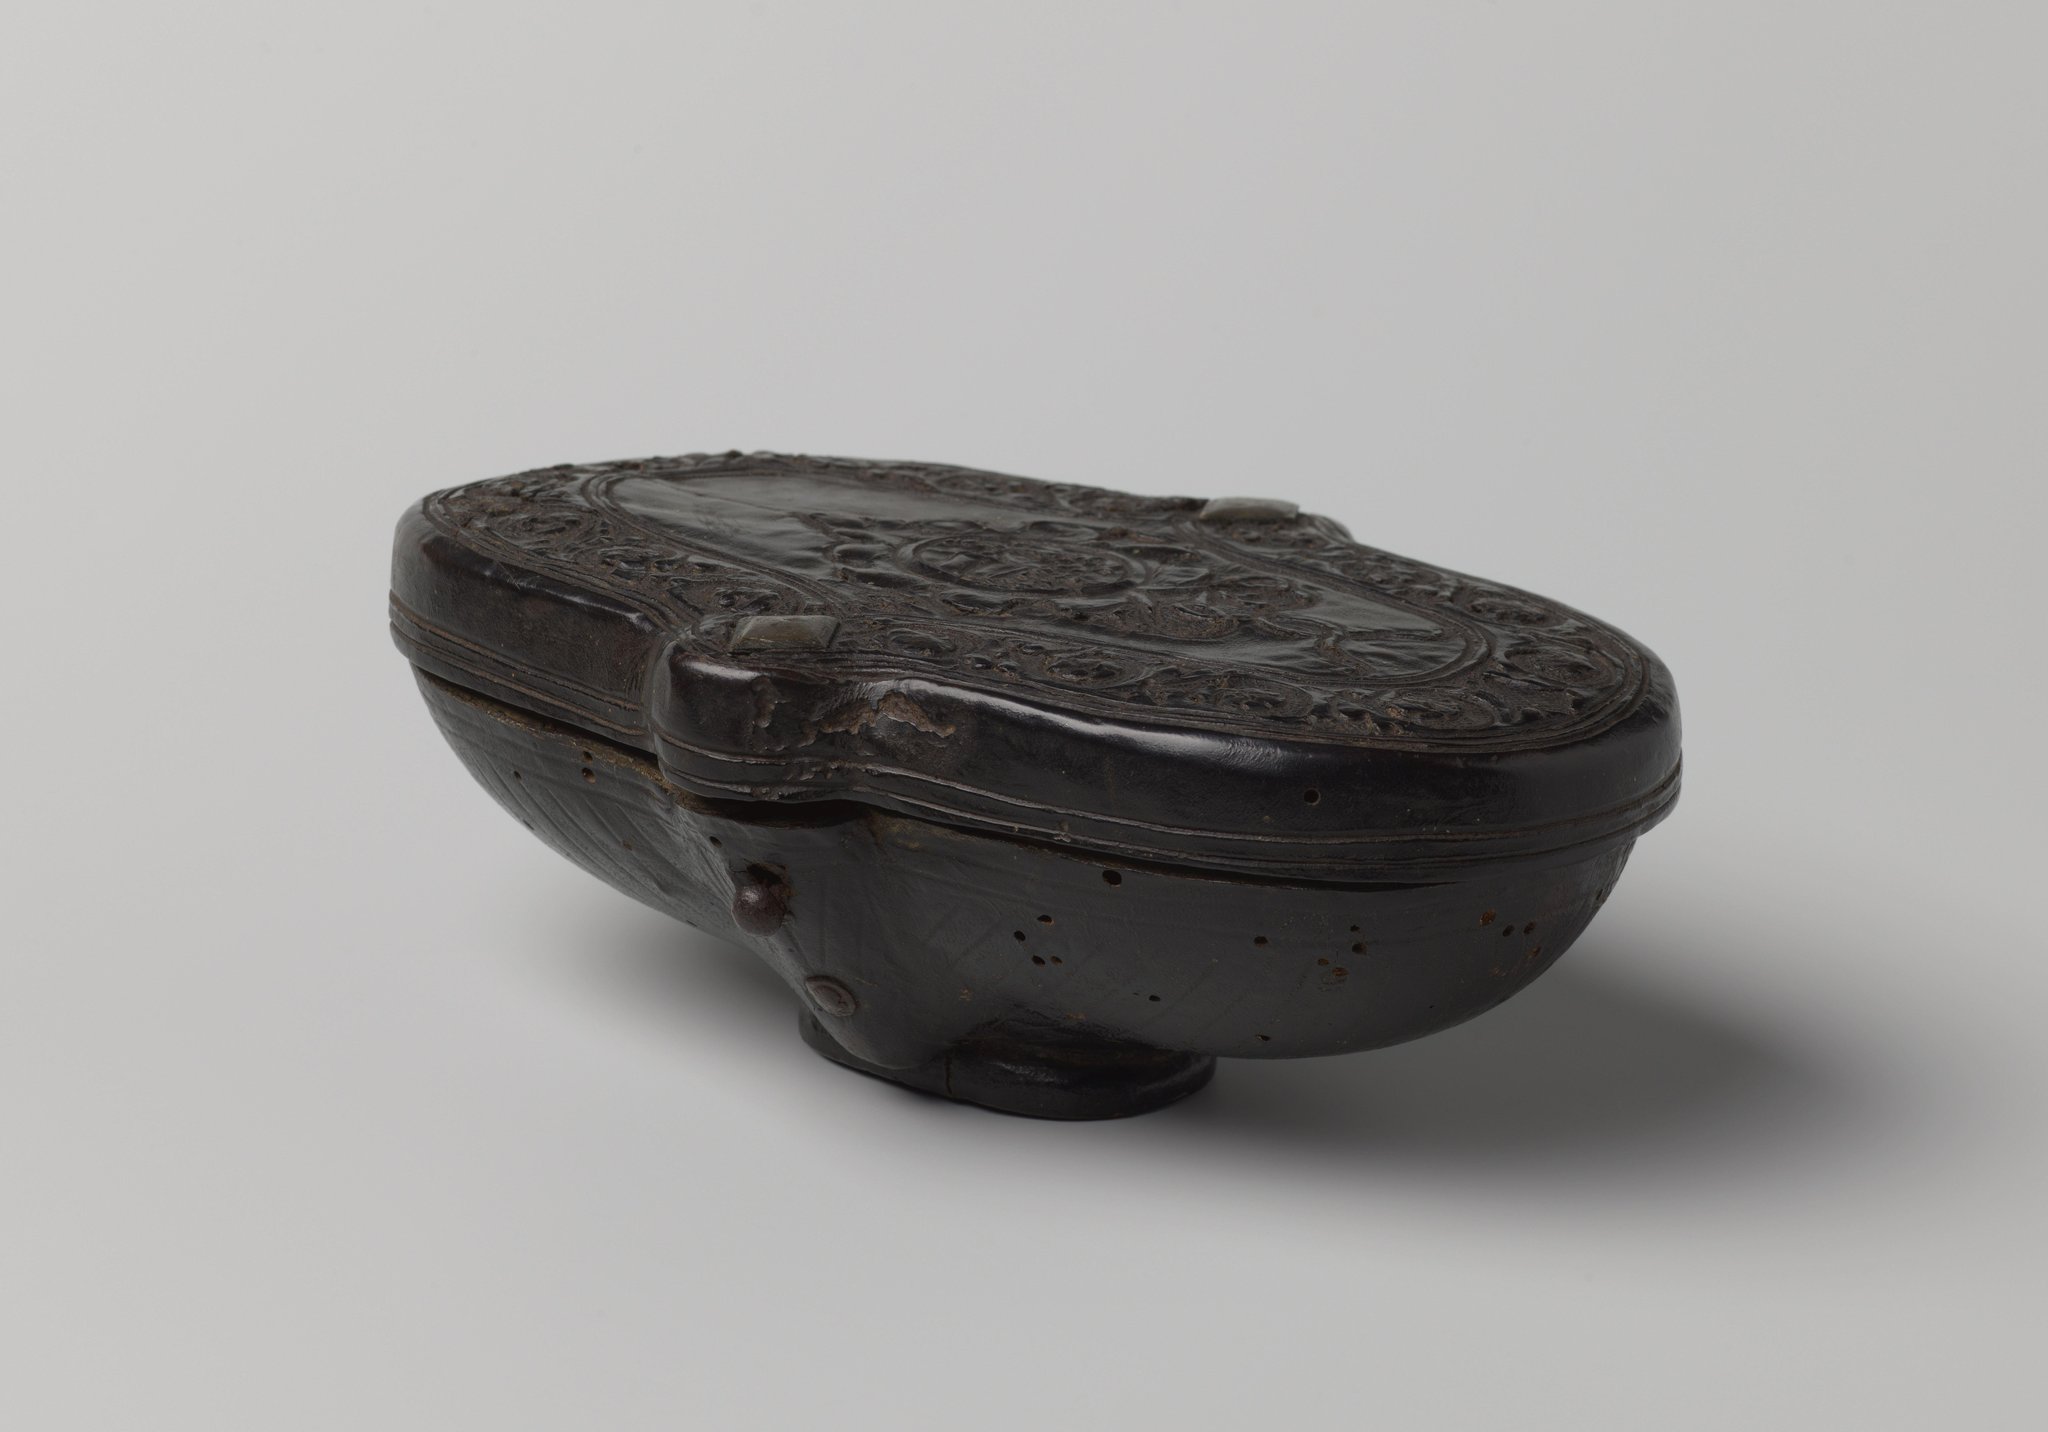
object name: verpakking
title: foedraal van hout, met leer overtrokken waarin geperste ornamenten en een wapenschild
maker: Anonymous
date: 1500-1600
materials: iron, leather, tin, wood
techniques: cutting, pressing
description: Etui van hout, ovaal, van buiten overtrokken met zwart leer, met daarop geperste en gesneden ornamenten. Op het deksel een wapenschild met een onduidelijk wapen in een aan een koord hangende cartouche. Ter plaatse van scharnier en slot twee ruitvormige kleine tinnen platen op de bovenkant van het deksel. Van binnen bekleed met leer, dat later groen geverfd is. Scharnier en slot zijn beschadigd.